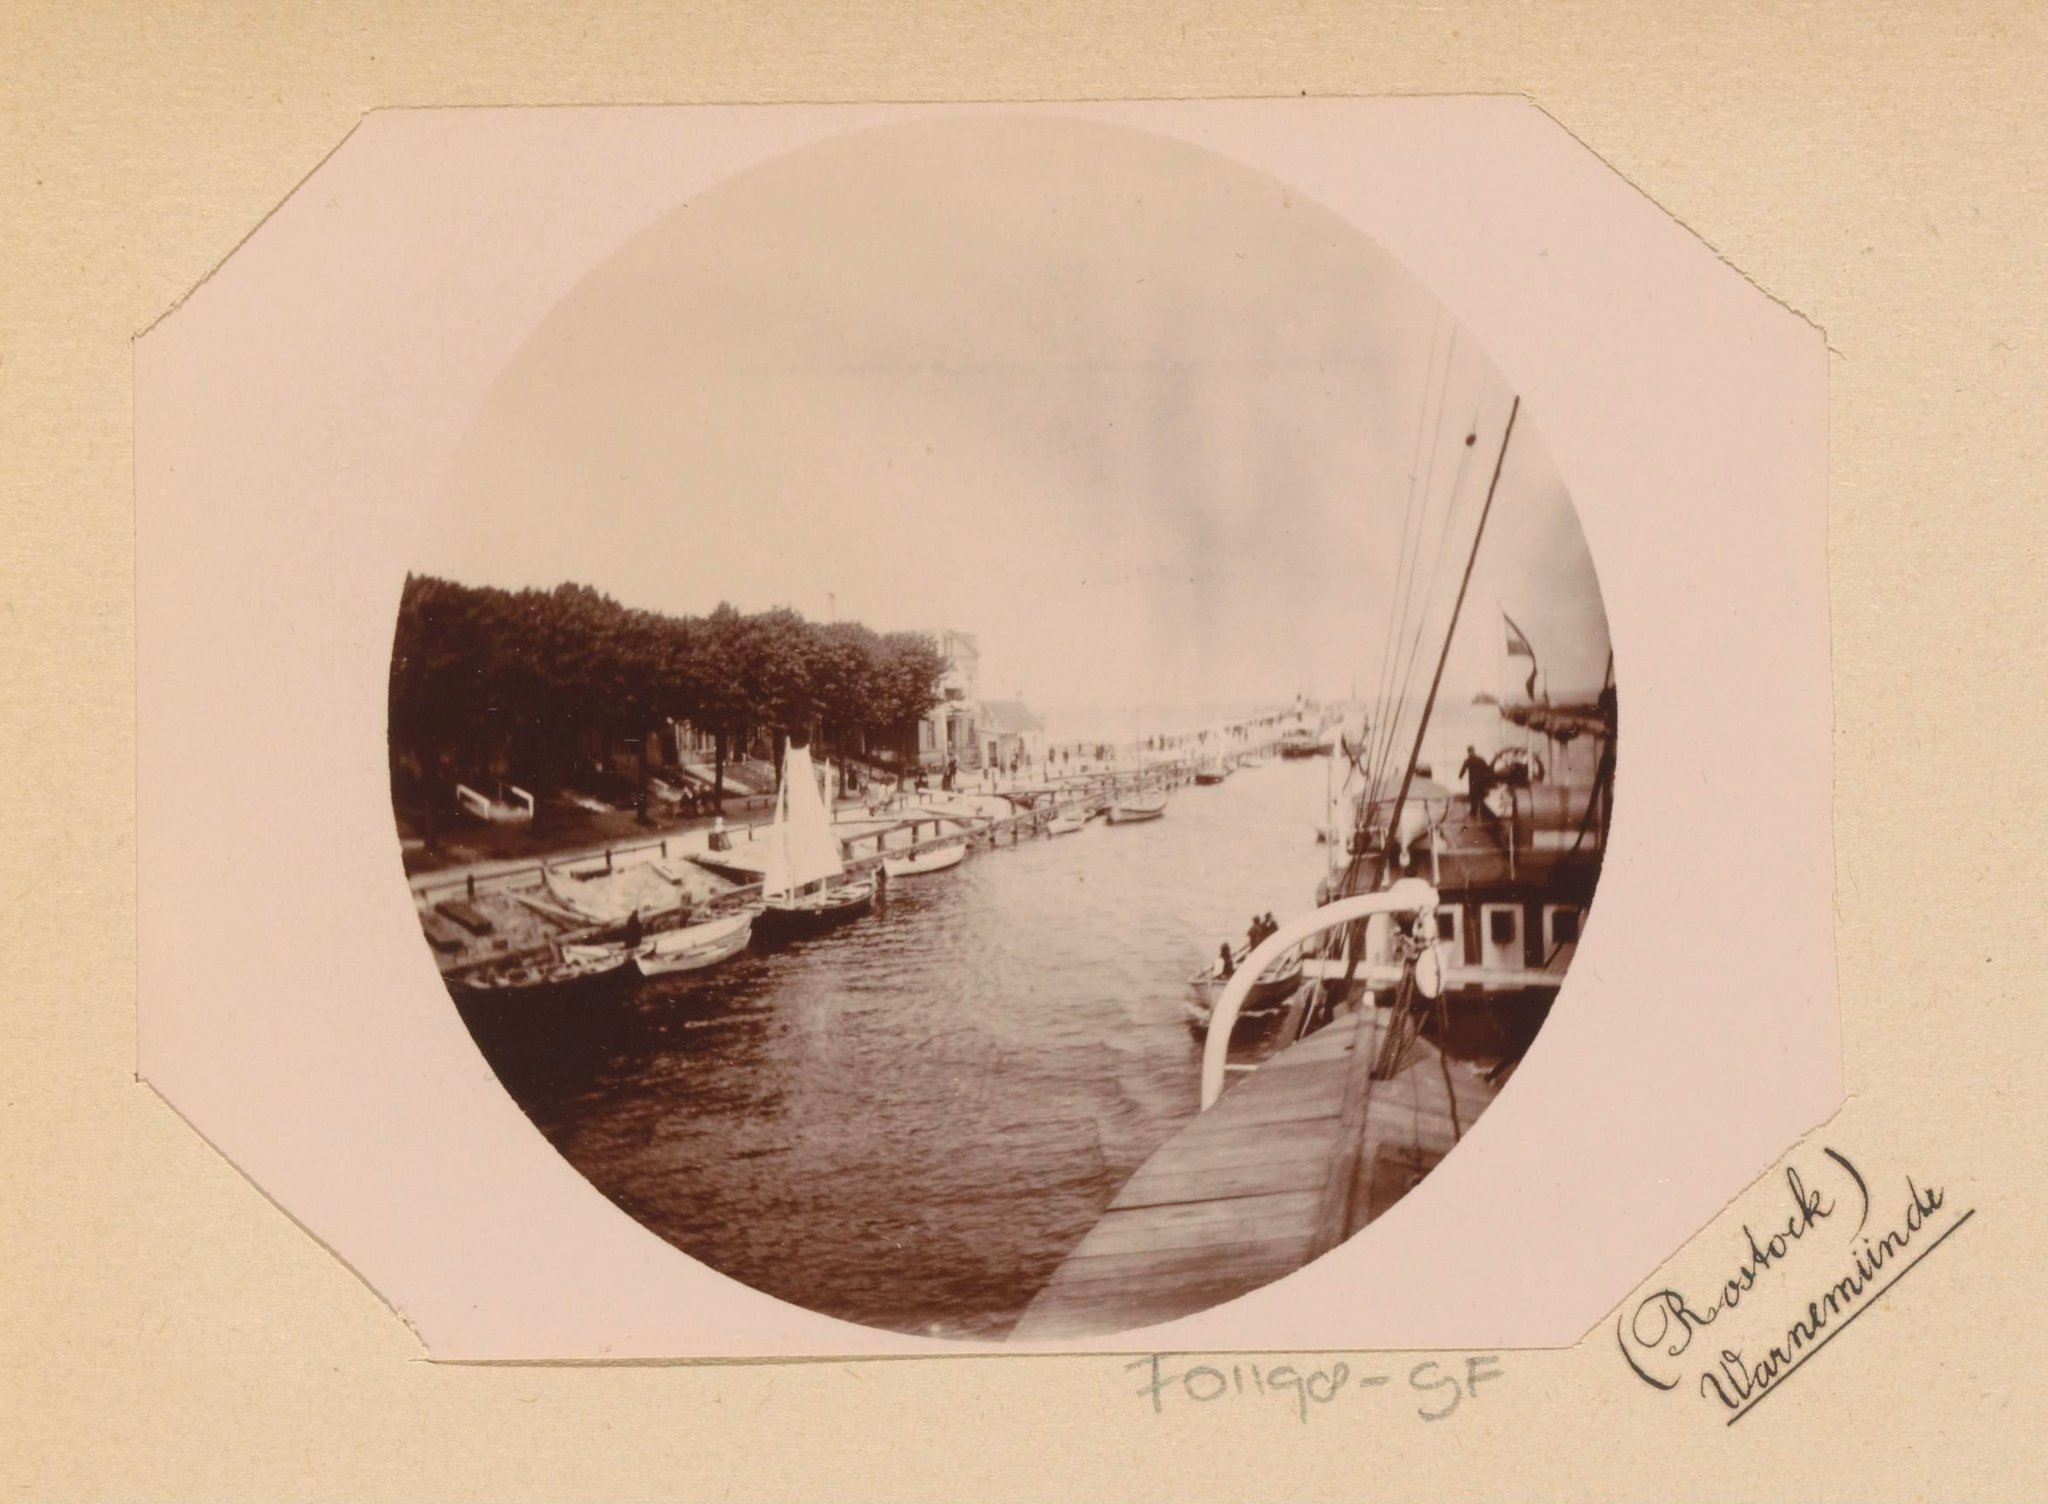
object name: album leaf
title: (Rostock) Warnemünde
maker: willem frederik piek jr.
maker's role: fotograaf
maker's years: 1874-1954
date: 1889-1893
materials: paper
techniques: gelatin silver print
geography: warnemünde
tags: harbour